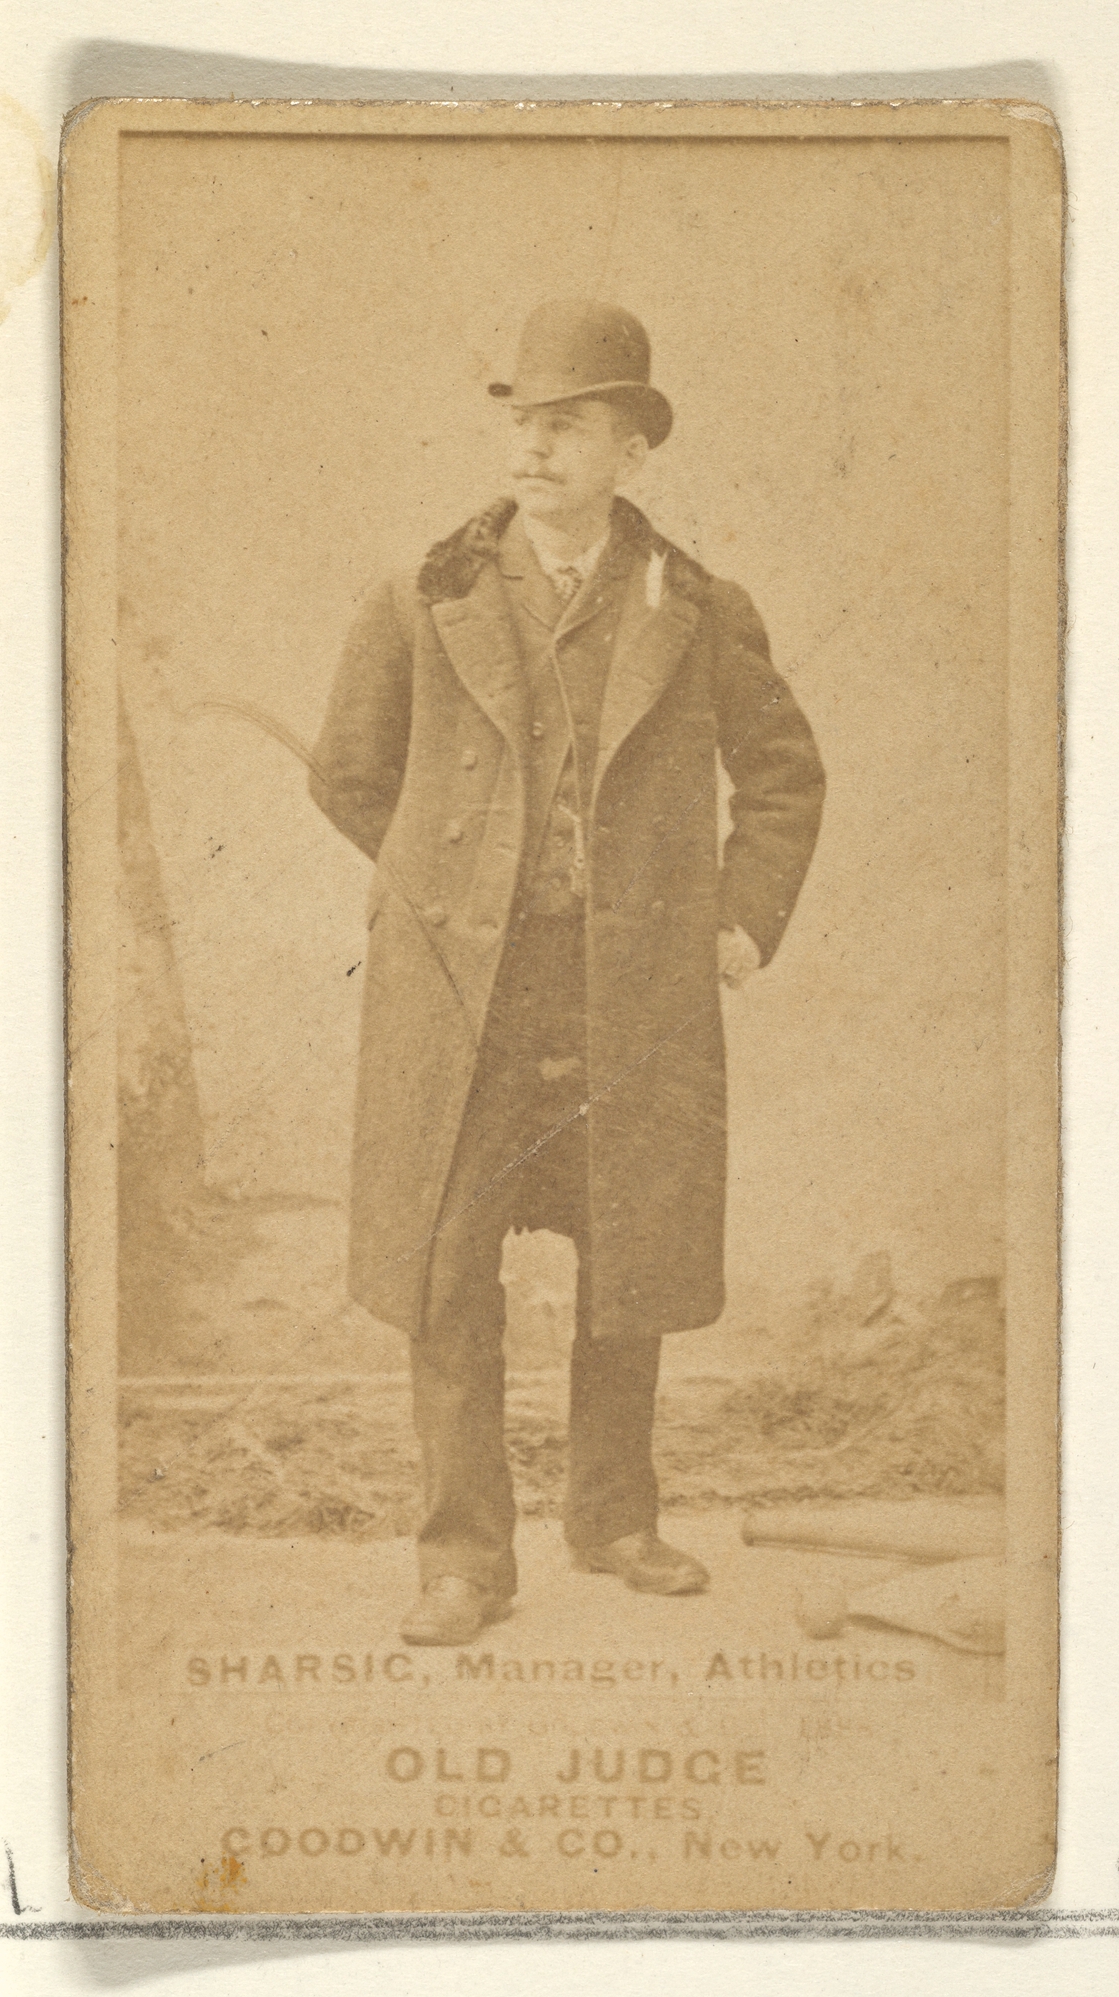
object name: baseball card, photograph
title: Sharsie, Manager, Philadelphia Athletics, from the Old Judge series (N172) for Old Judge Cigarettes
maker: goodwin & company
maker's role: publisher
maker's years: 1850-1950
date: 1887-1890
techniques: albumen silver print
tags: men,portraits,baseball,athletes